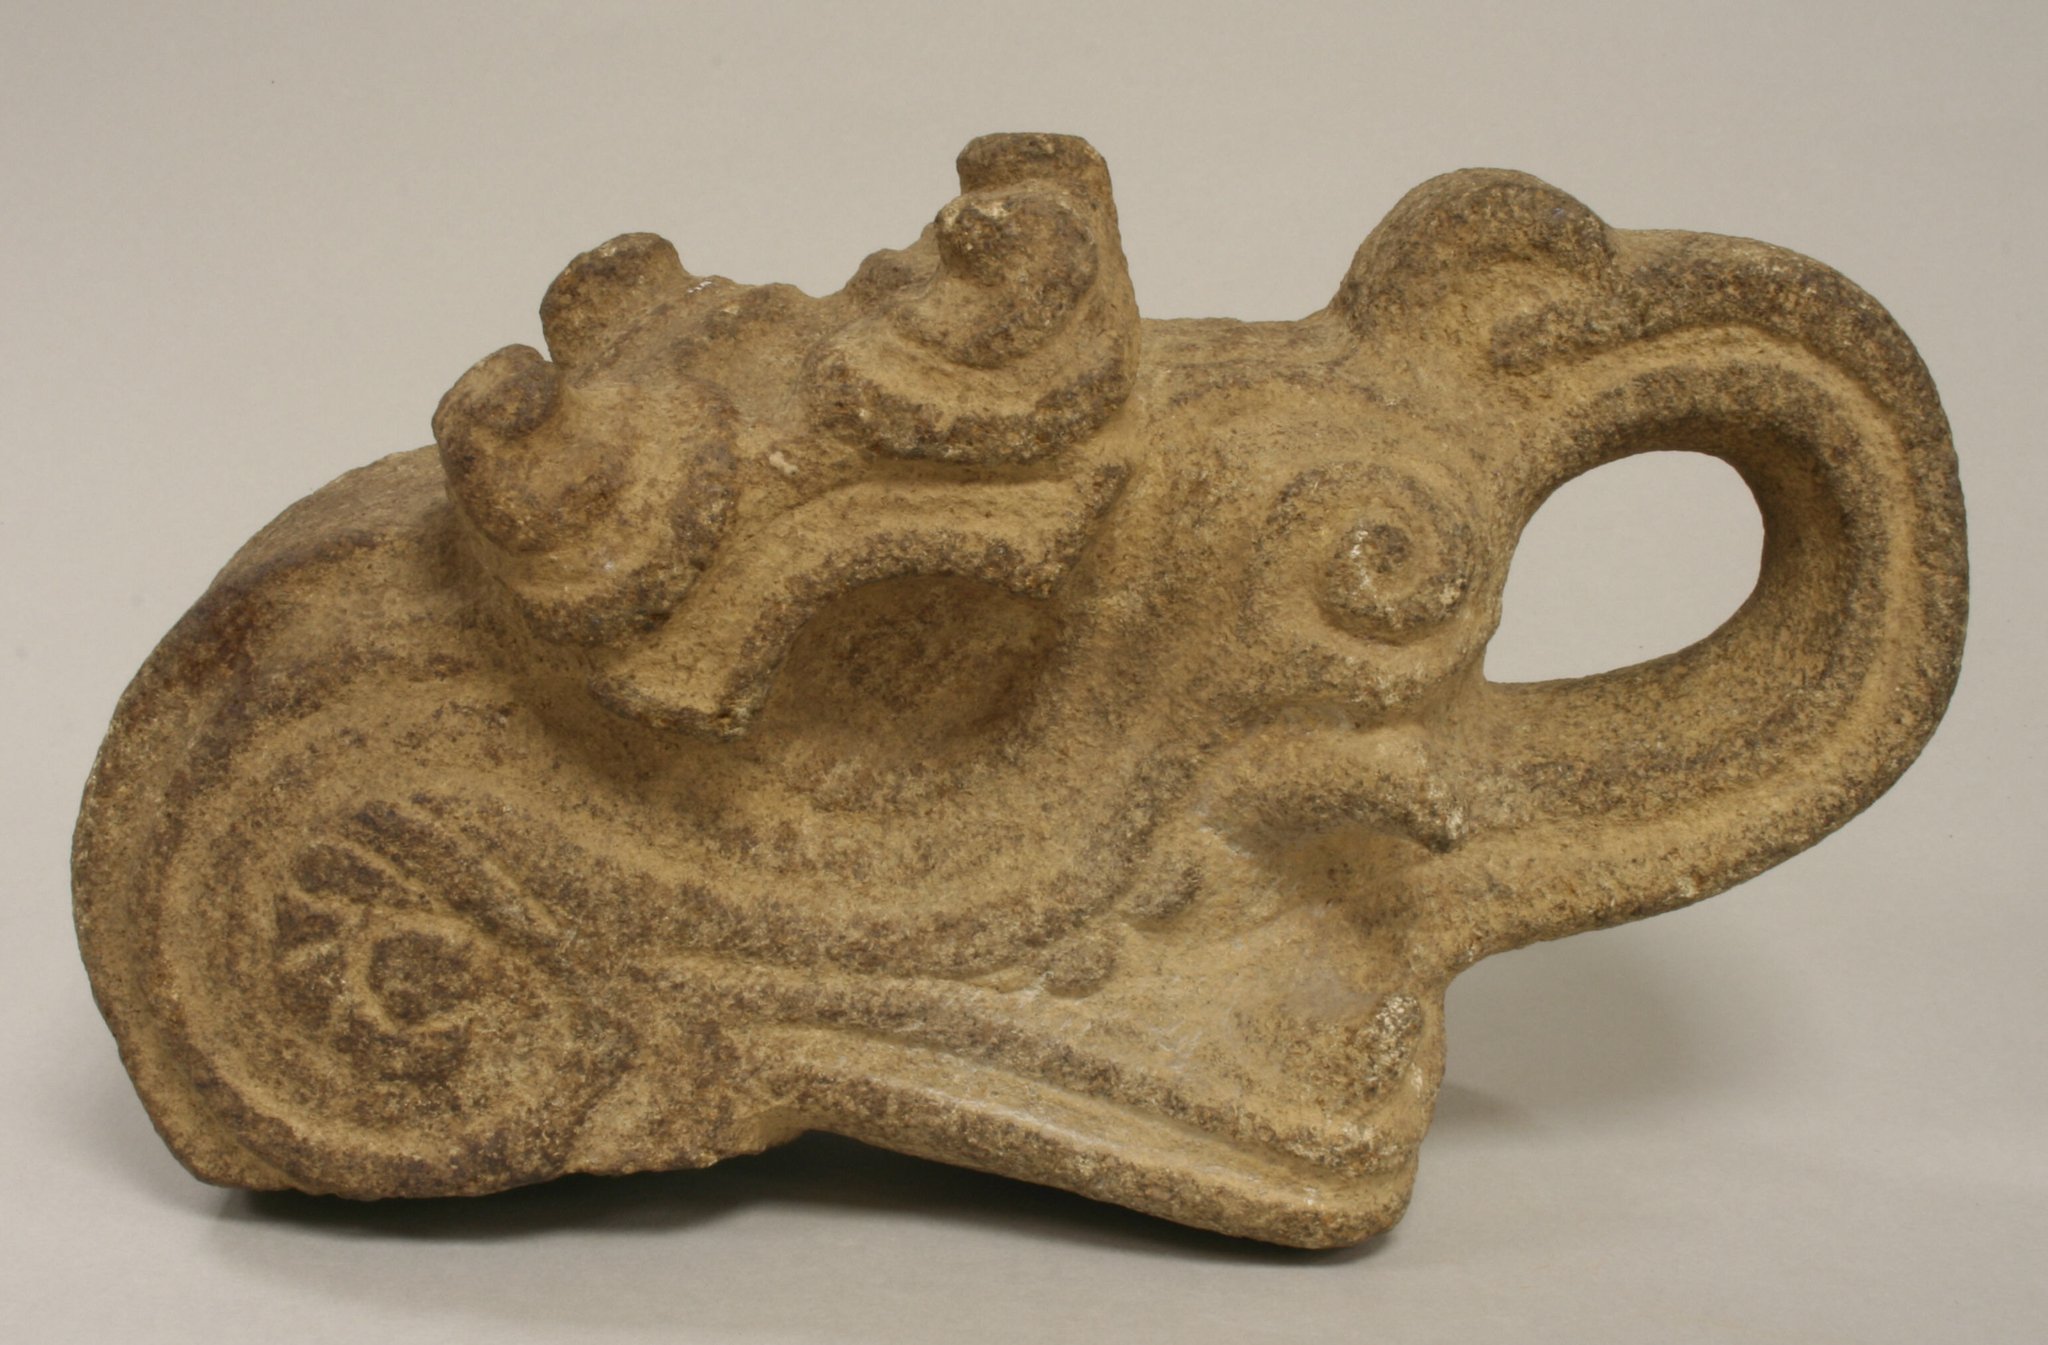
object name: metate fragment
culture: maya-cocal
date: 1101-1400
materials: stone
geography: honduras